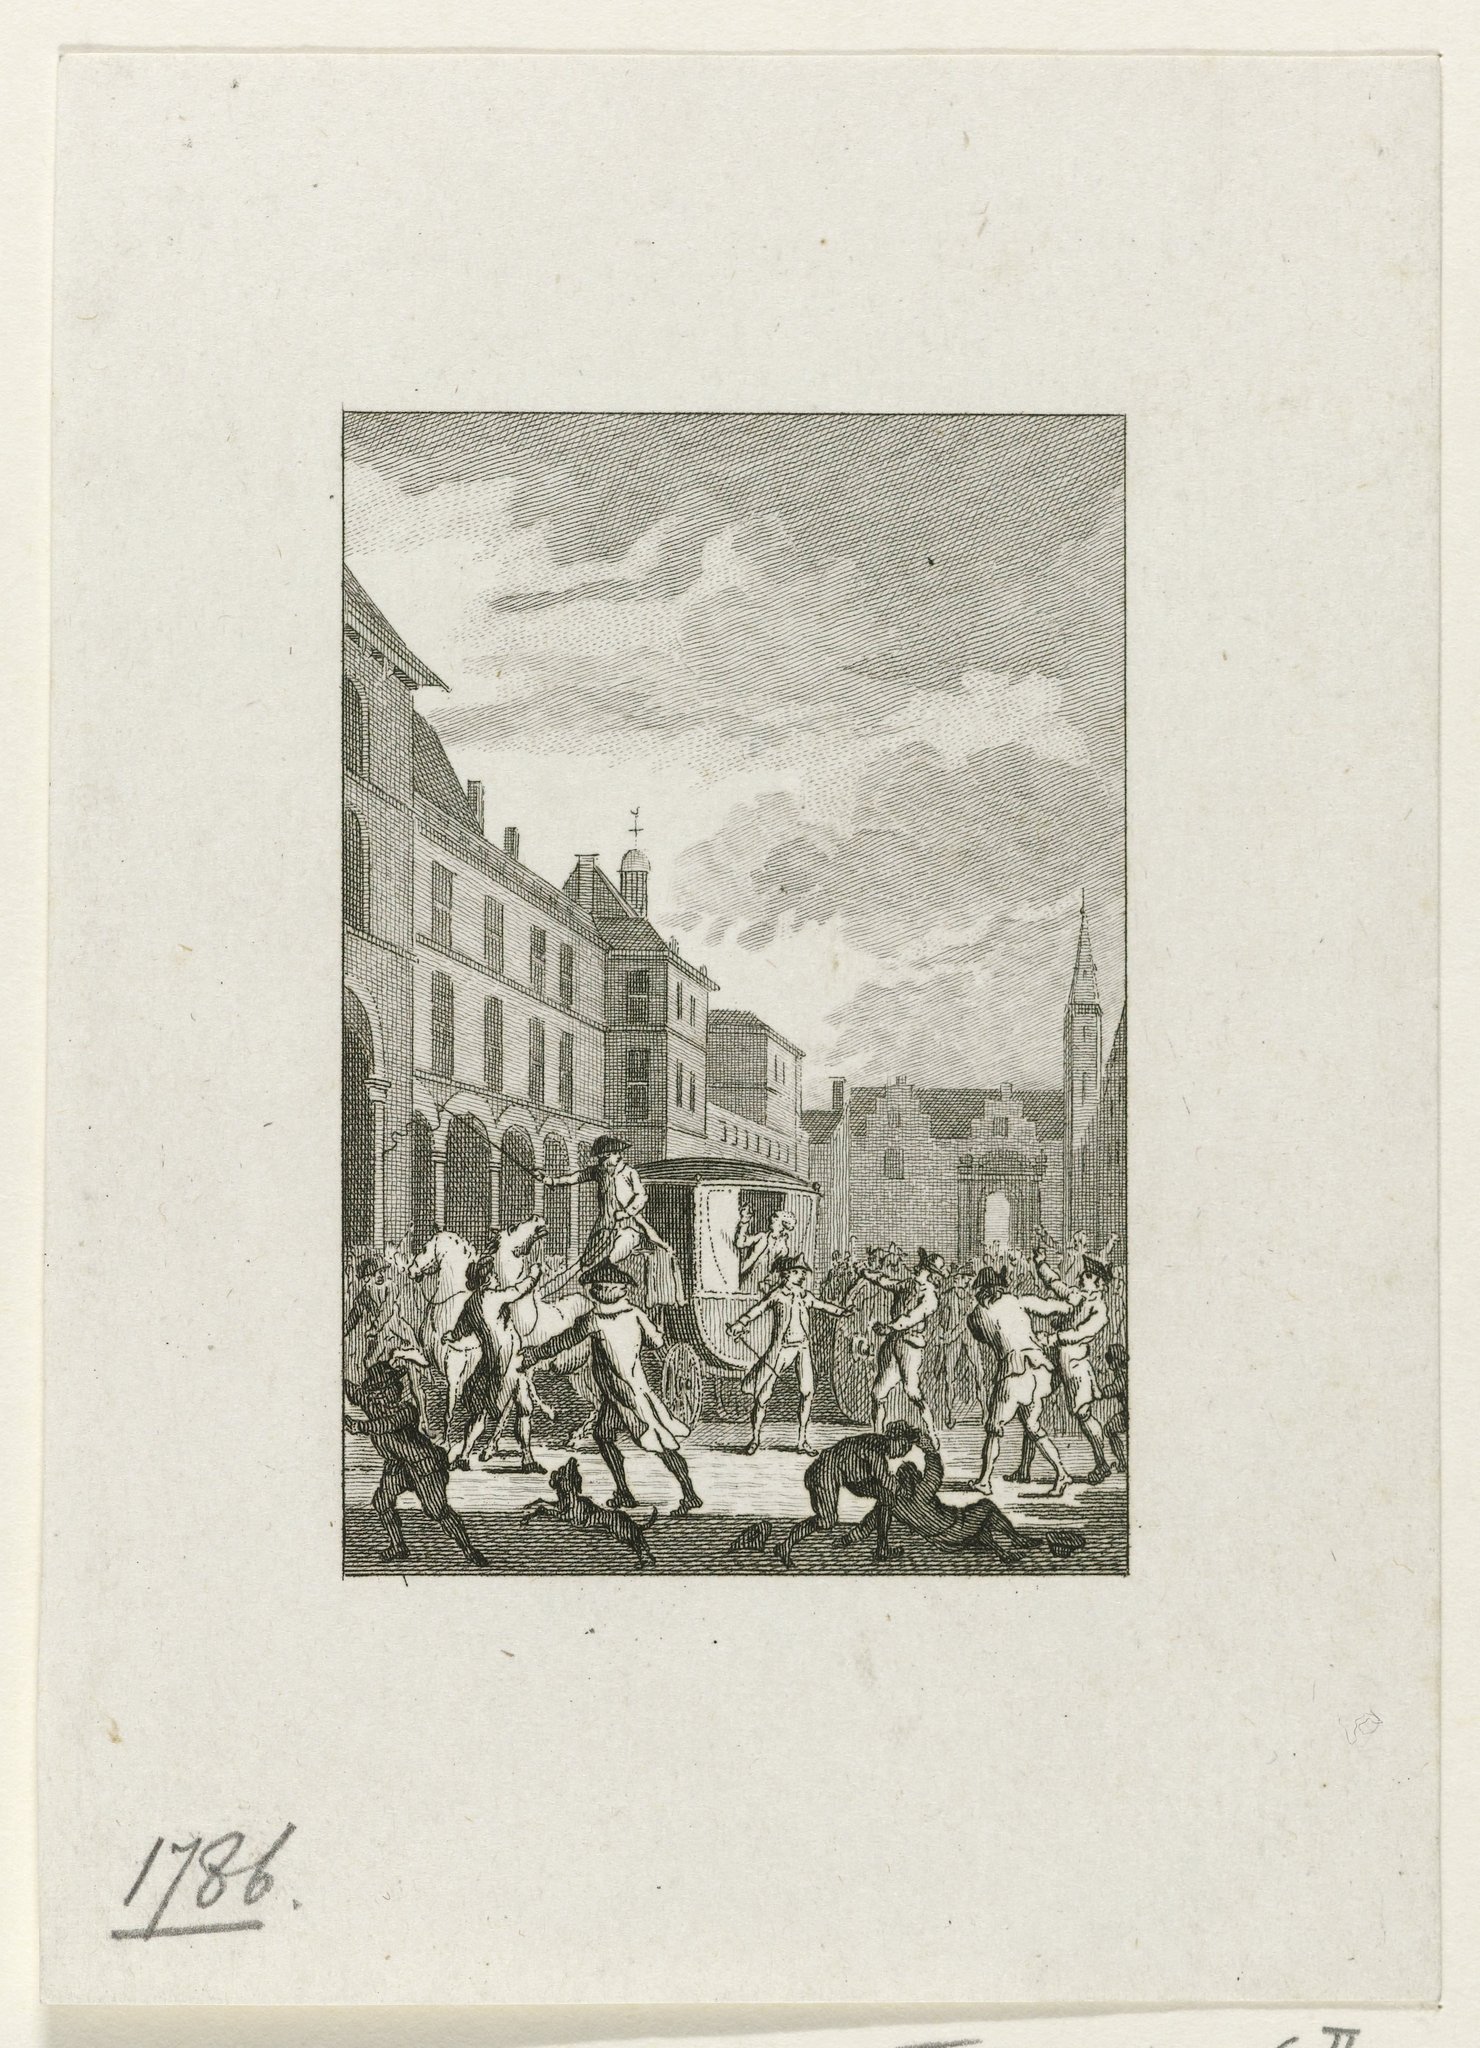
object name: print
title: Aanslag op het rijtuig van de gedeputeerden van Dordrecht, 1786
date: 1786-1795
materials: paper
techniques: engraving, etching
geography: northern netherlands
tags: revolutionary action (violent)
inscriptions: collector's mark: Lugt 2228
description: Aanslag door de Haagse pruikenmaker F. Mourand op het rijtuig van de gedeputeerden van Dordrecht, de heren Gevaerts en De Gijzelaar, als zij door de Stadhouderspoort het Binnenhof op willen rijden, 17 maart 1786.